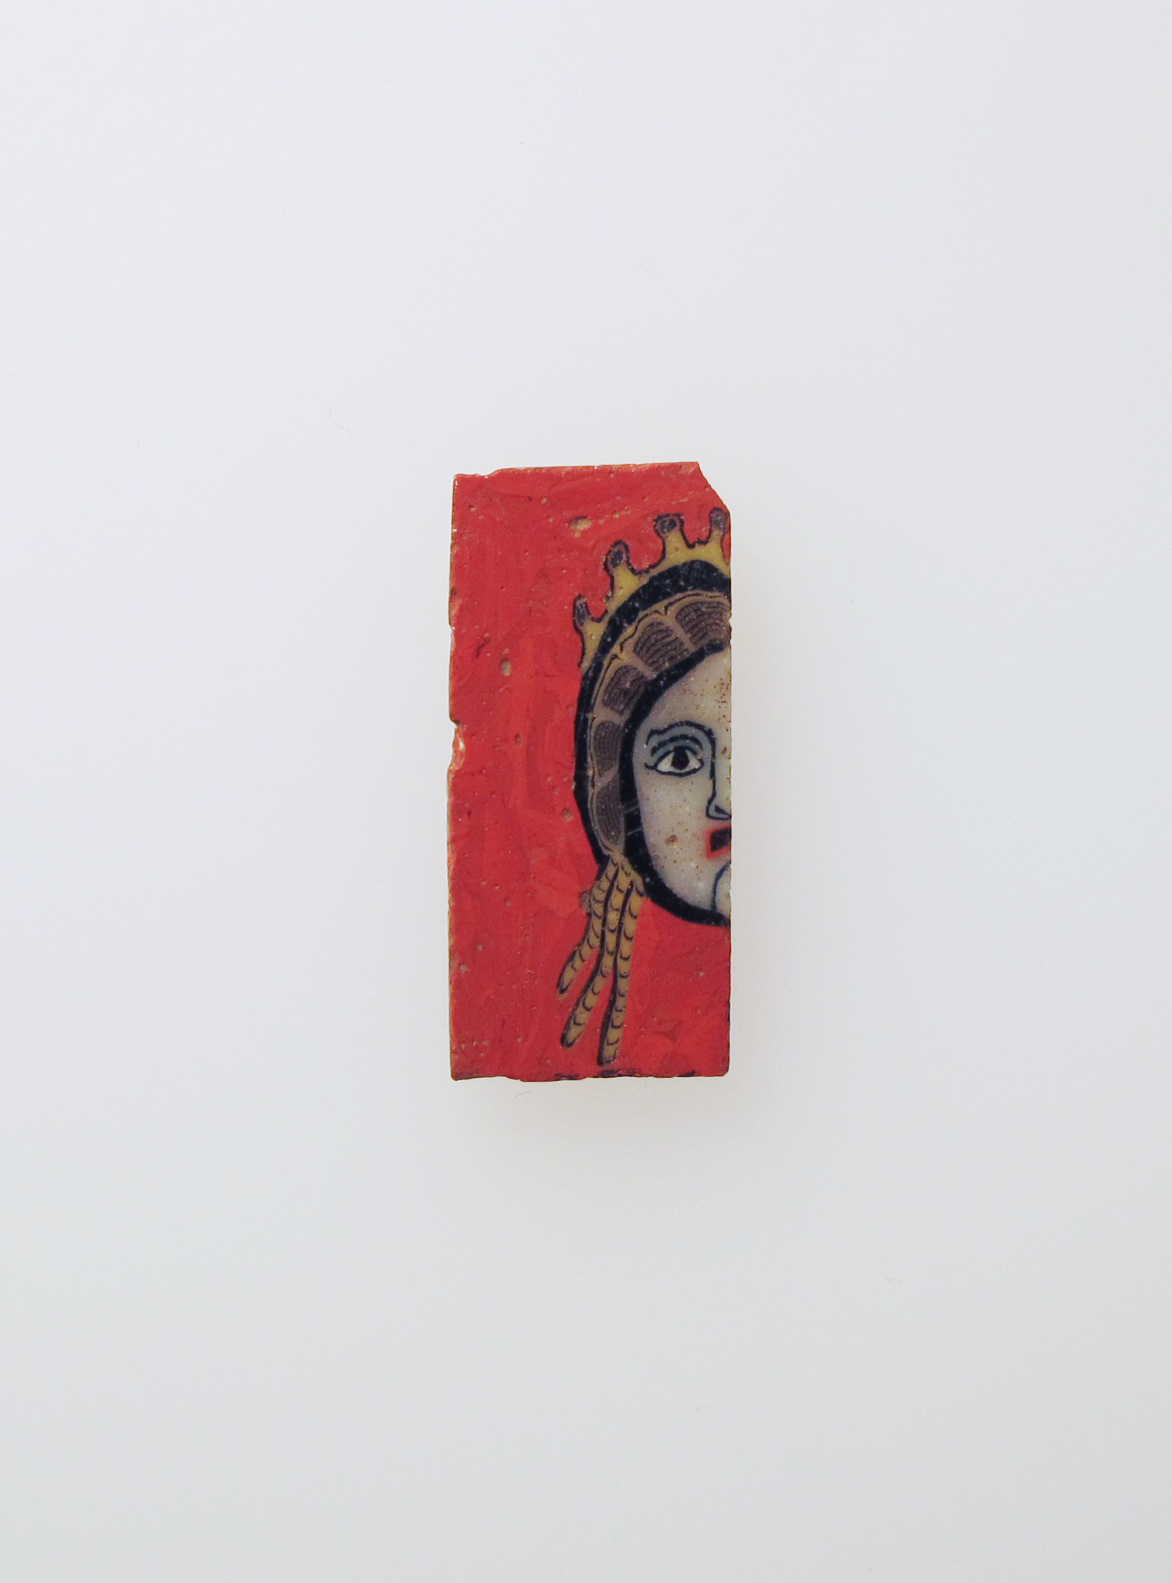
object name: mosaic plaque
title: Mosaic glass inlay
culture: roman, egyptian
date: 100 BCE-100 CE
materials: glass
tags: faces,heads